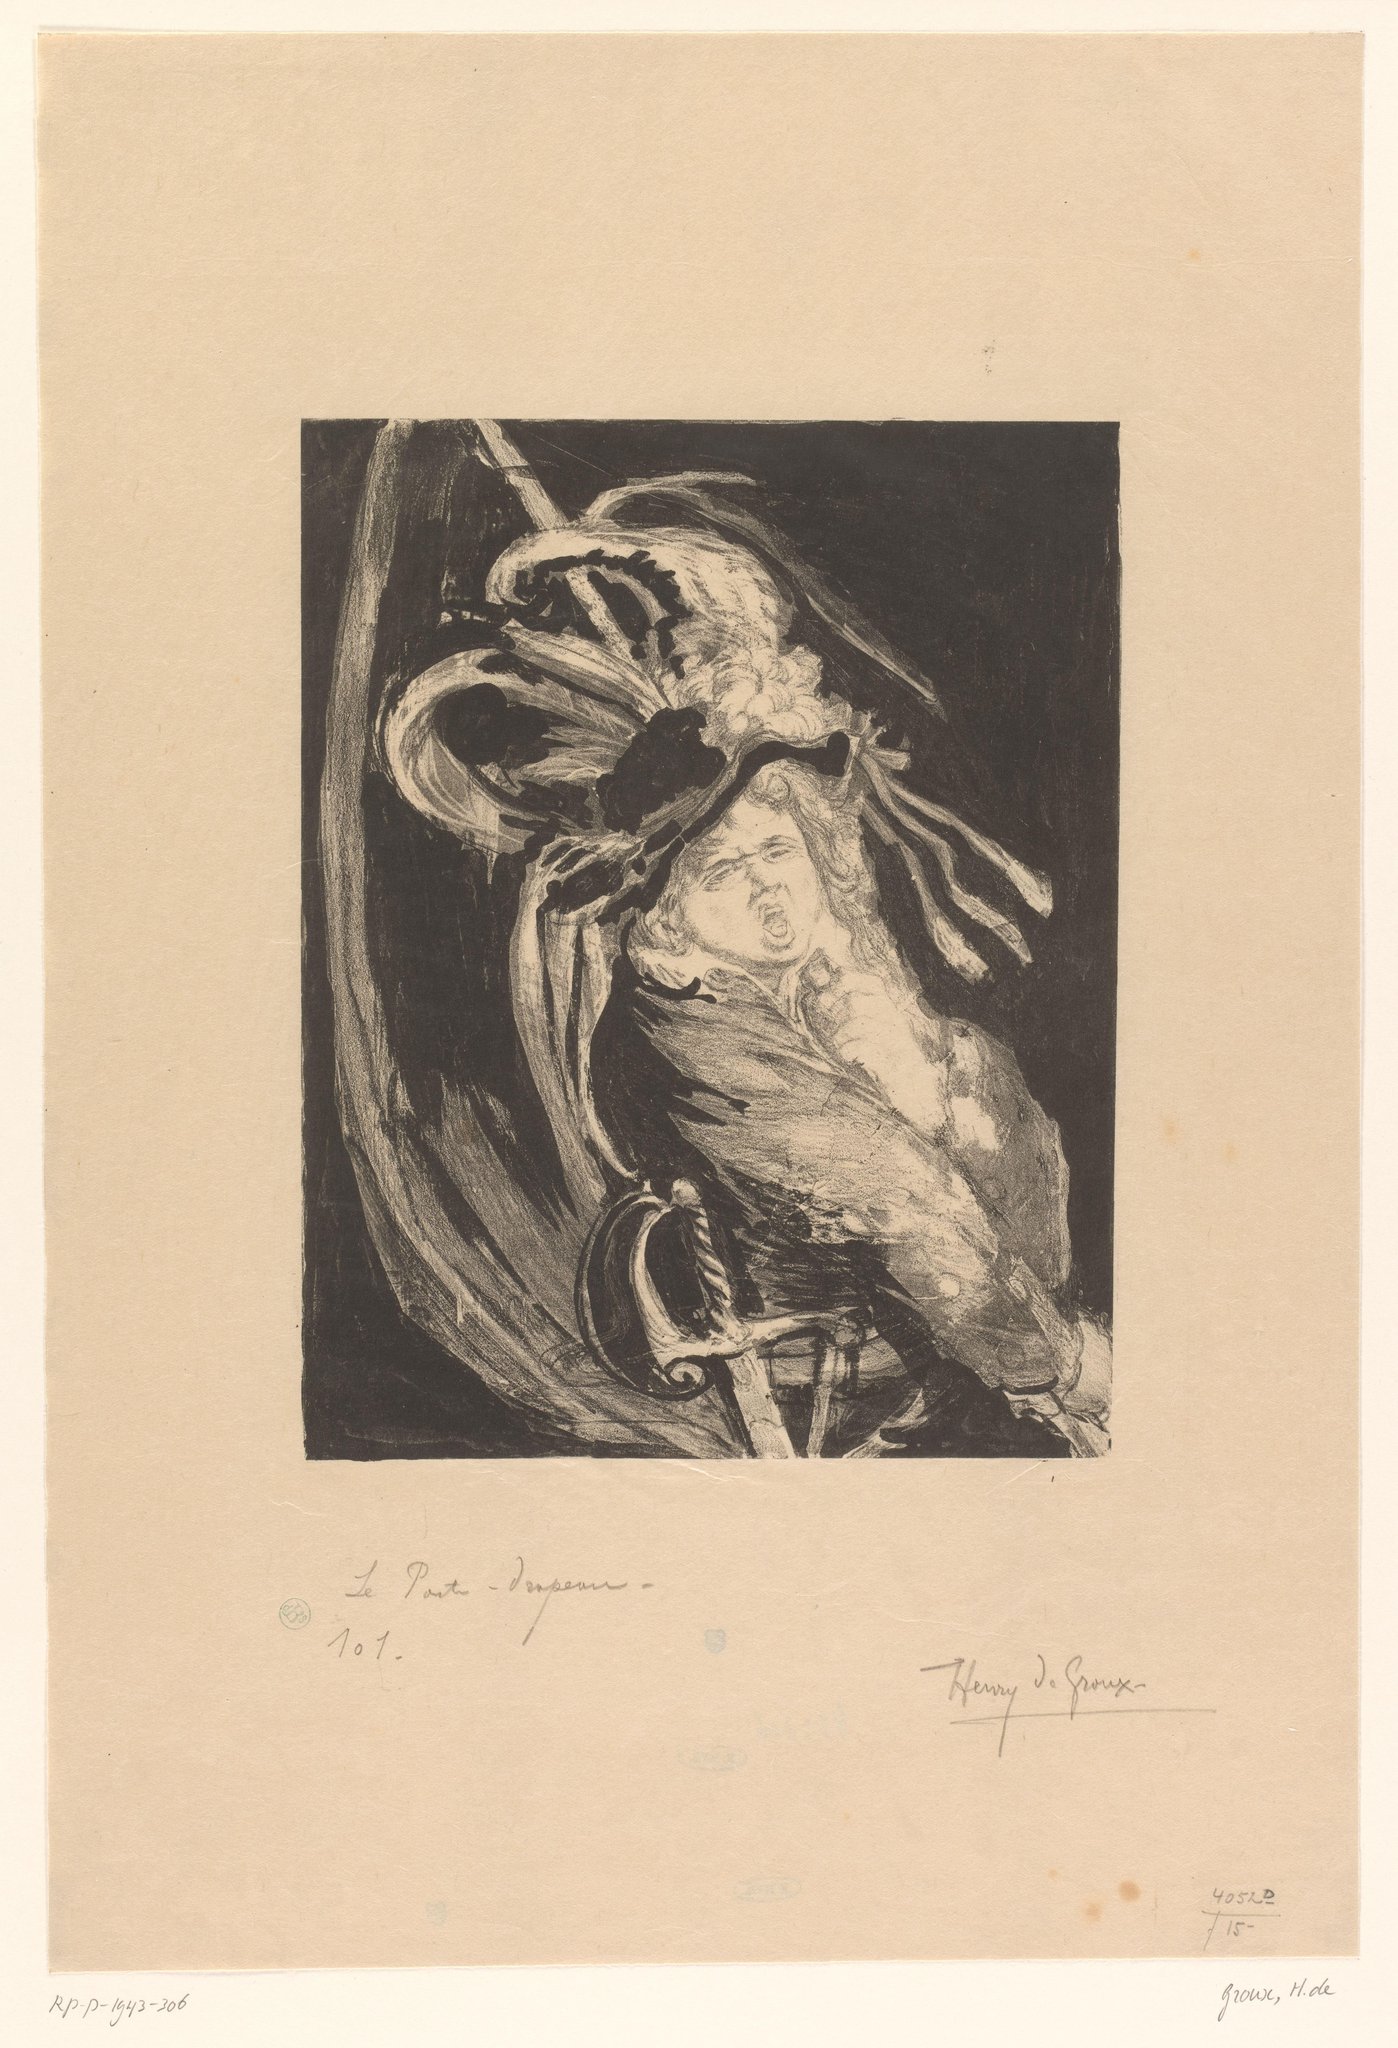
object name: print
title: Vaandeldrager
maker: henri de groux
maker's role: painter, print maker, sculptor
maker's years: 1866-1930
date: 1893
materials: paper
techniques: lithograph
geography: paris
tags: adult man, (military) standard-bearer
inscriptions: collector's mark: Lugt 2228, collector's mark: Lugt 733, collector's mark: Lugt 2760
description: Prent verschenen in: L'Estampe Originale 4 (1893).